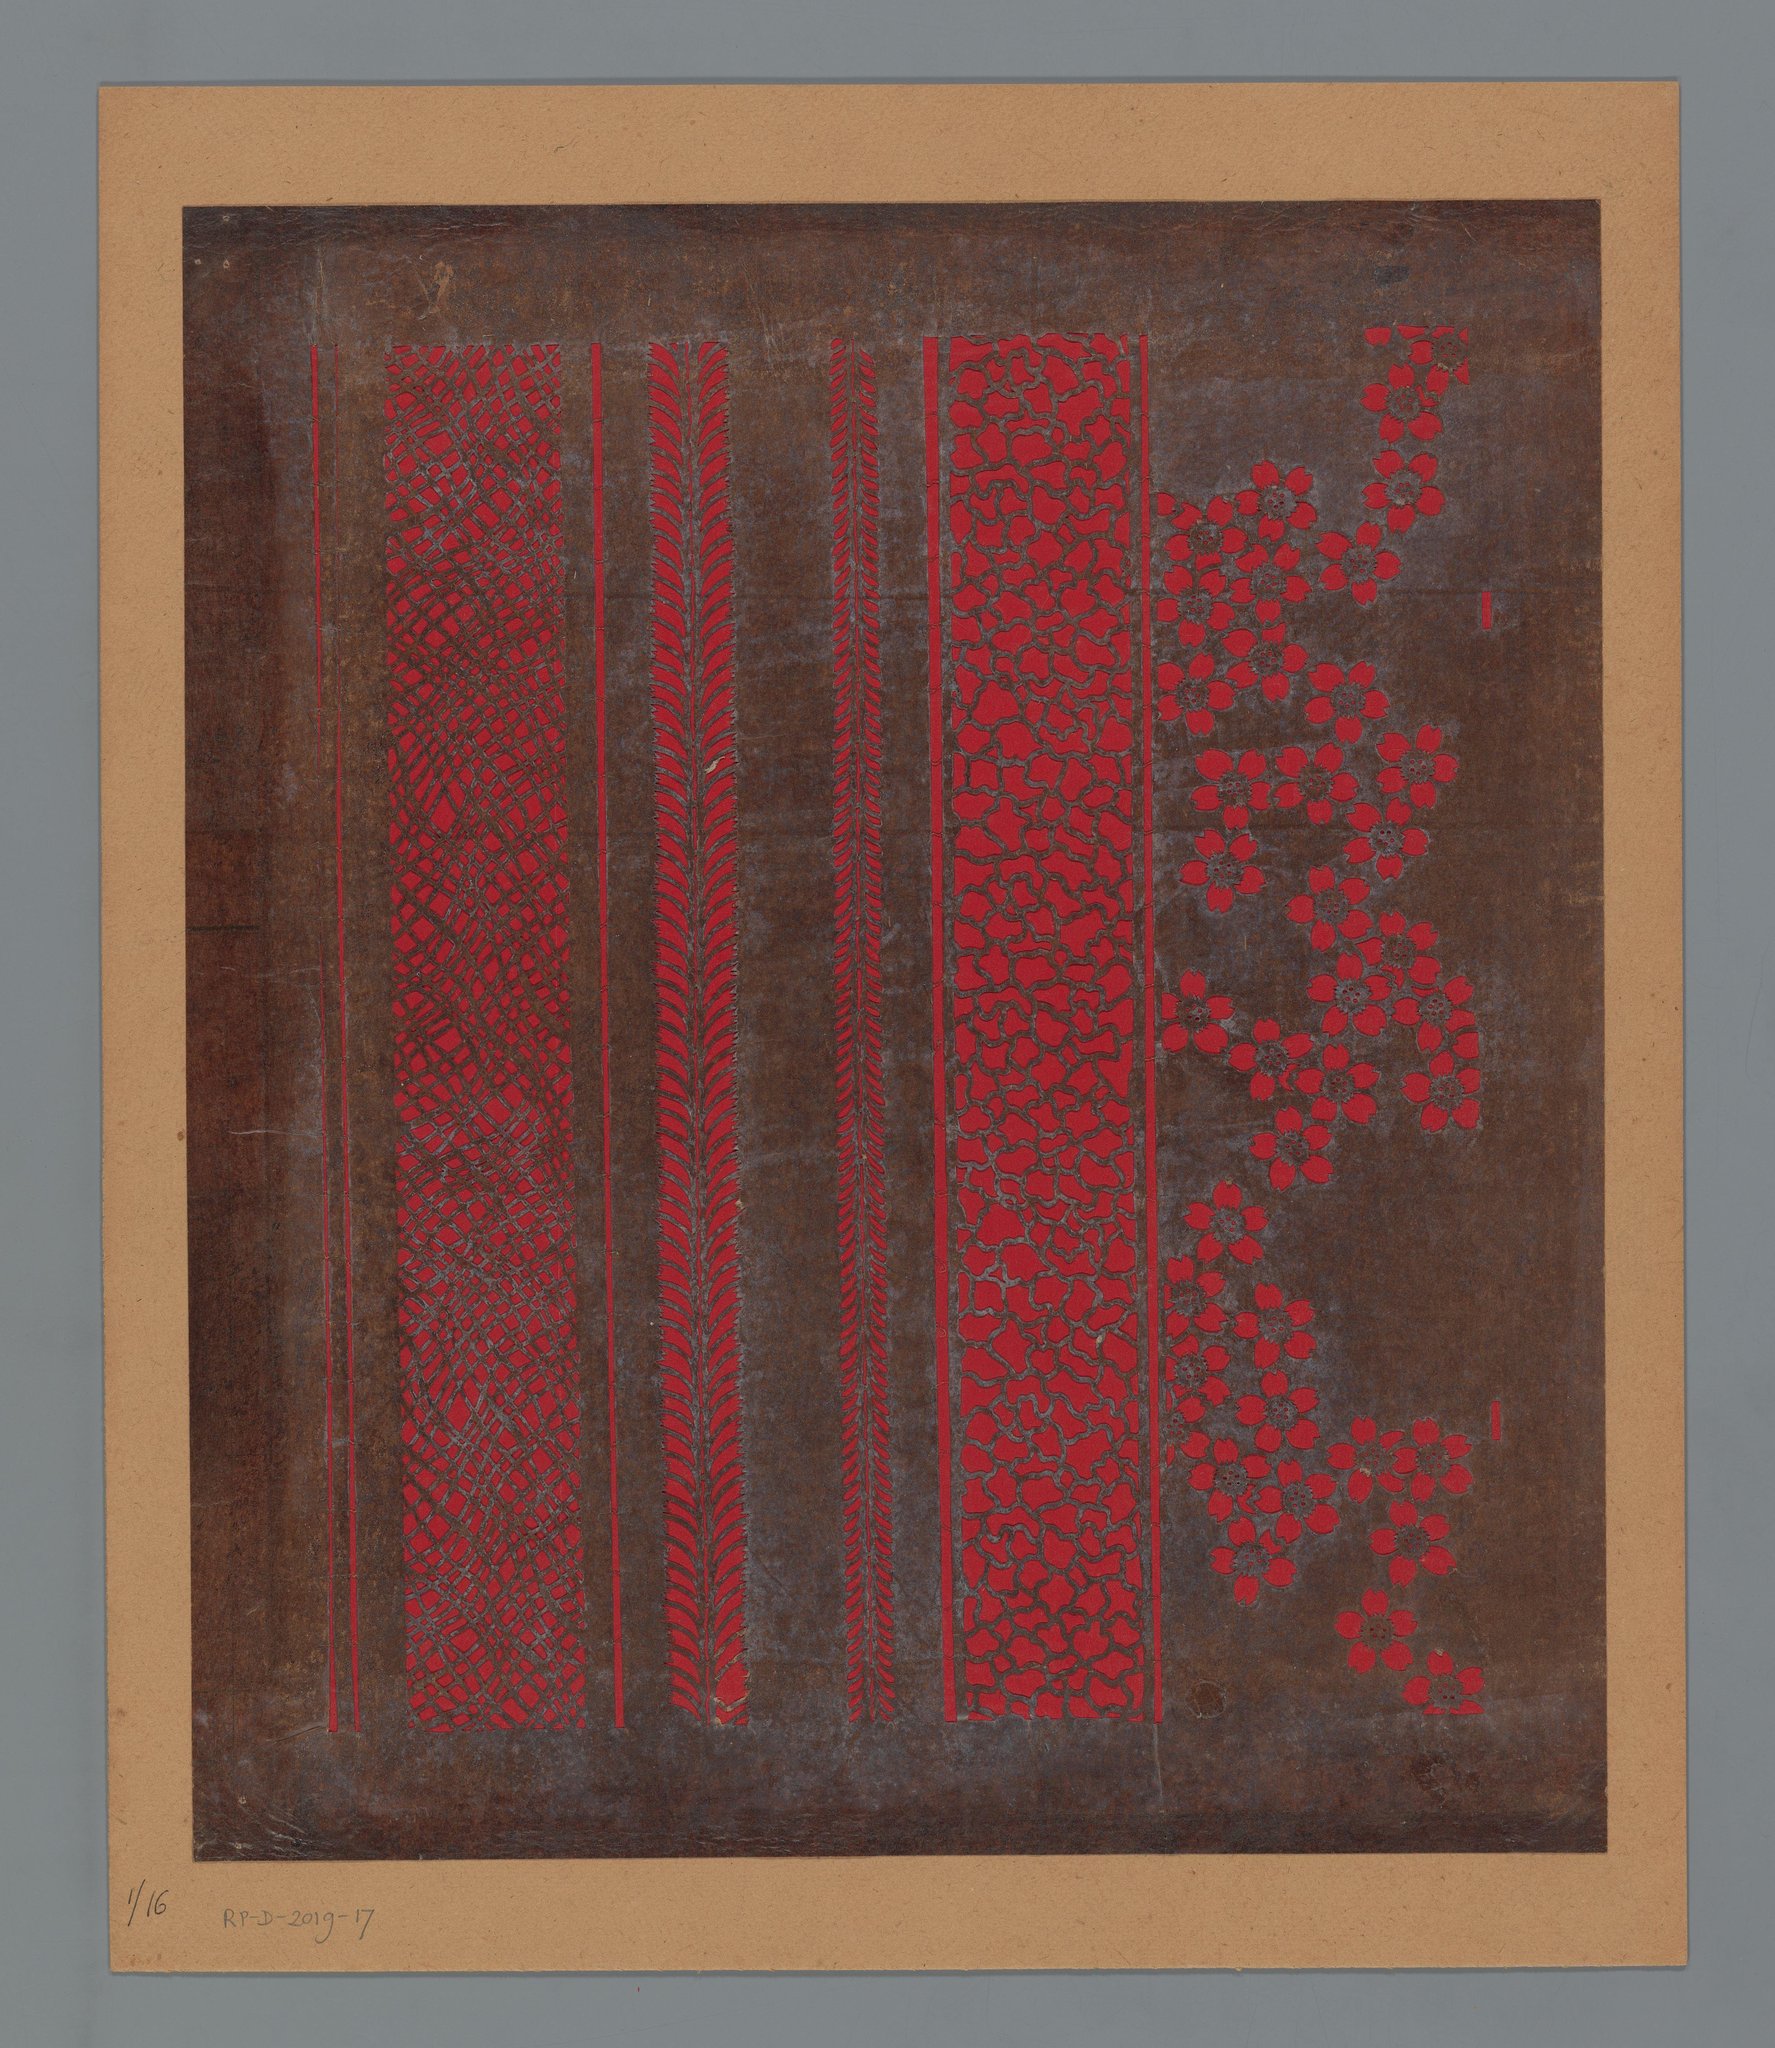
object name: katagami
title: Sjabloon met verticale banen en bloemen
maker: Anonymous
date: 1800-1909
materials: paper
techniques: cutting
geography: japan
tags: fantasy ornament, flowers ~ ornament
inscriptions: number: ‘1/16’, stamp: ‘Museum van Kunstnijverheid Haarlem’, stamp: ‘Afgeschreven W...’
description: Japanse sjabloon (katagami) met een patroon van verschillende verticale ornamentele banen met rechts een slinger van bloemen.